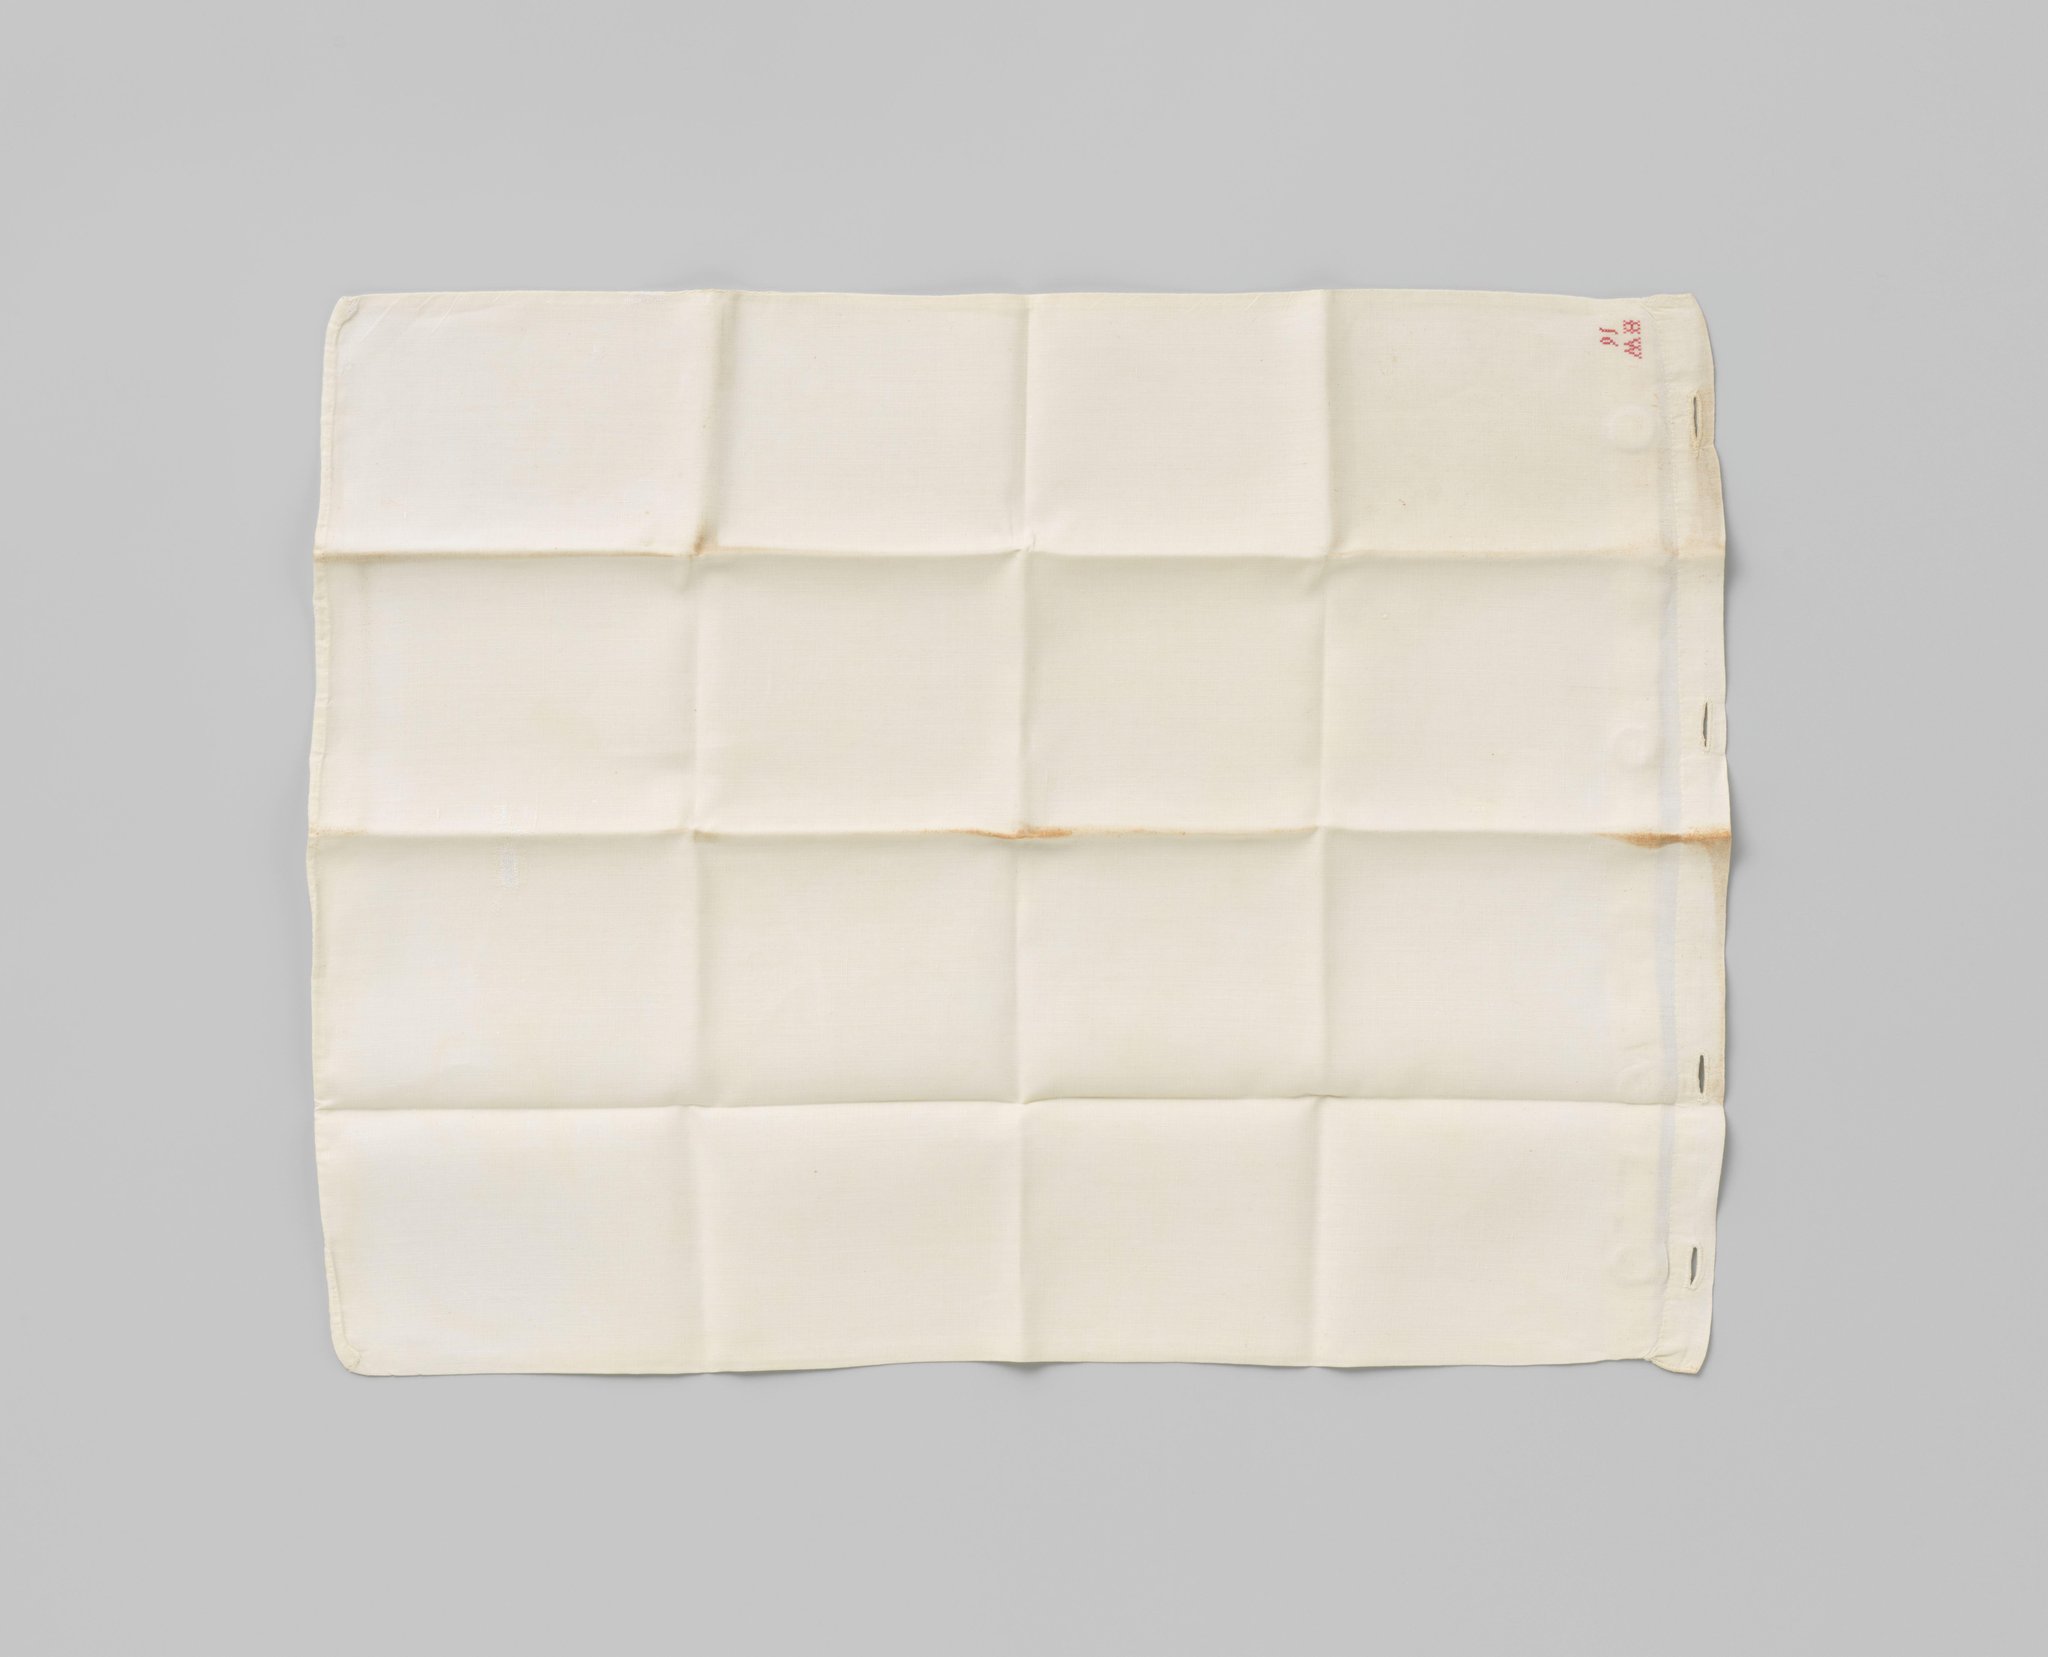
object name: lendensloop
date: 1850-1870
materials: linen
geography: northern netherlands